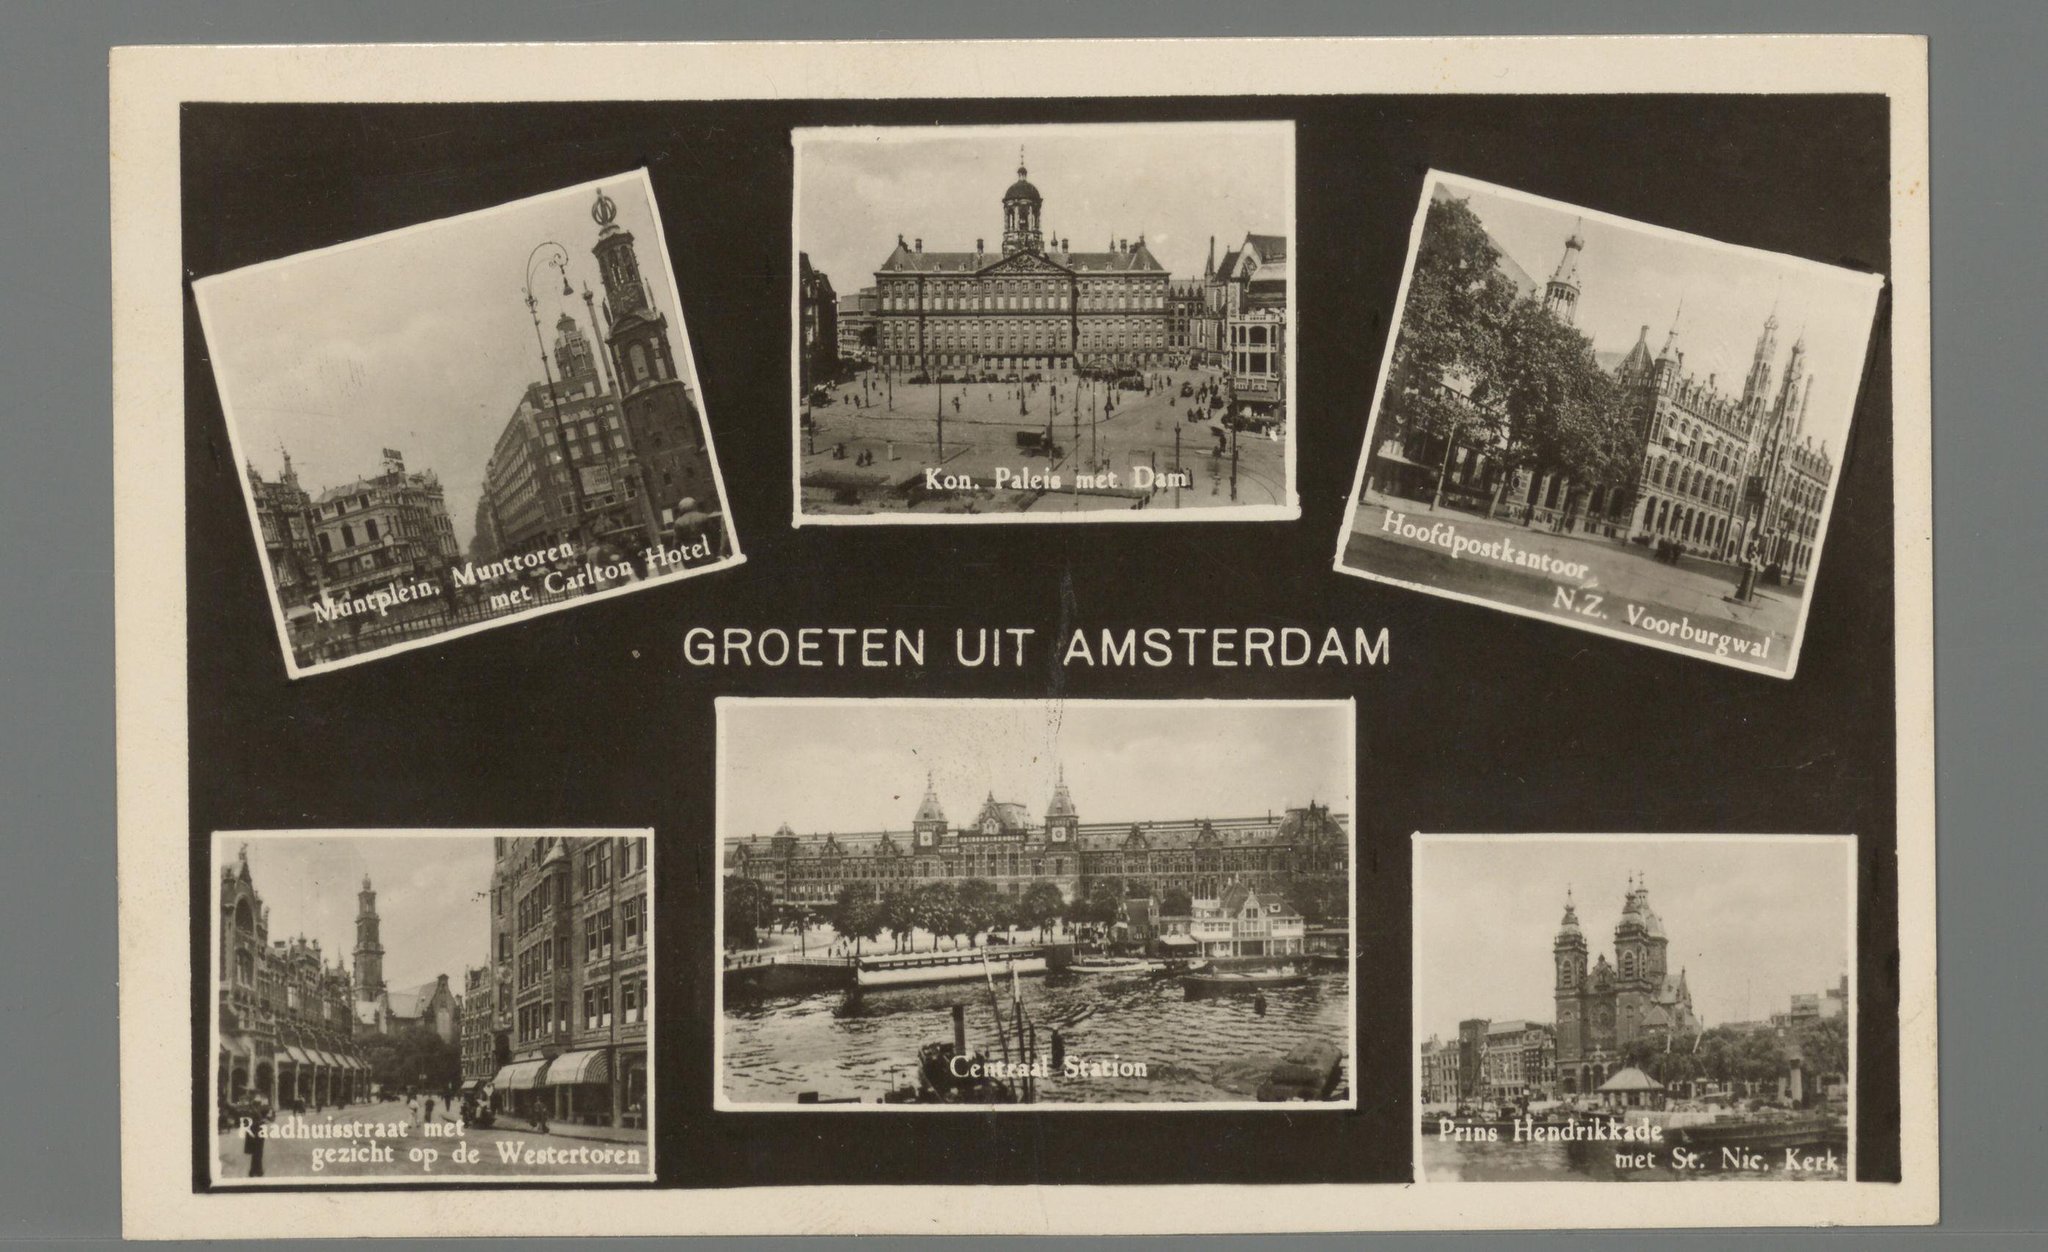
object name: photograph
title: Groeten uit Amsterdam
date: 1947-1954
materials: photographic support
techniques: photography, writing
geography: oosterhout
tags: square, place, circus, etc., city-view in general; 'veduta', front façade, amsterdam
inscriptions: postage stamp